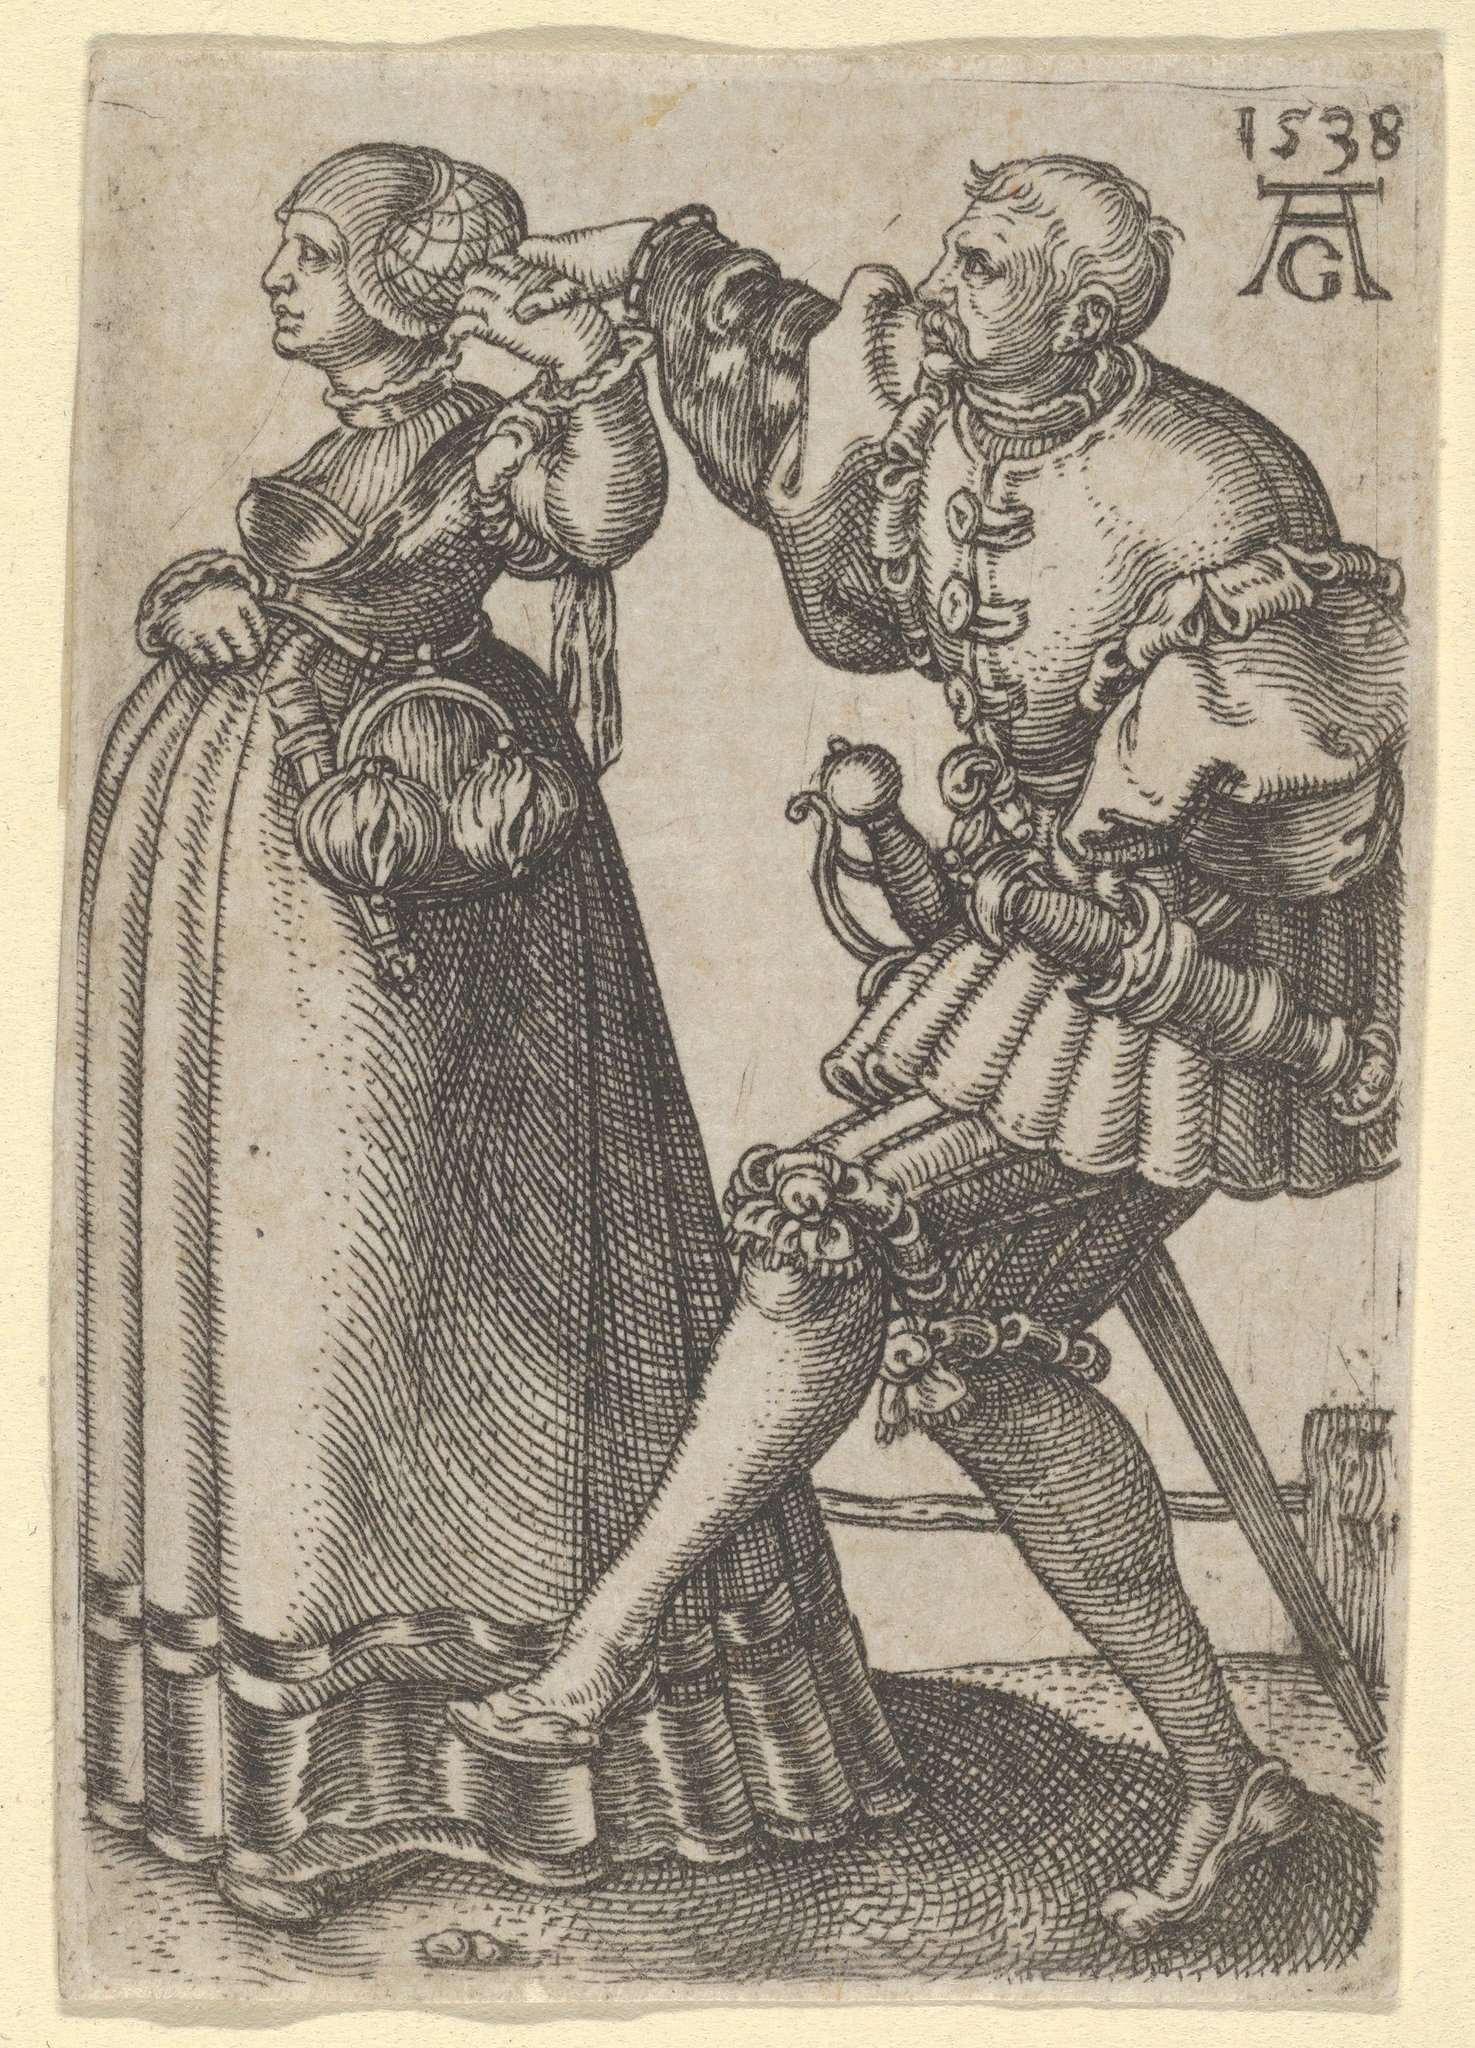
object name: print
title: Dancing Couple, with the Male Figure Mid-Step, from "The Small Wedding Dancers"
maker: heinrich aldegrever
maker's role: artist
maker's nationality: german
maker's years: 1502-1561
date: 1538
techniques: engraving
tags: couples,men,women,dancing